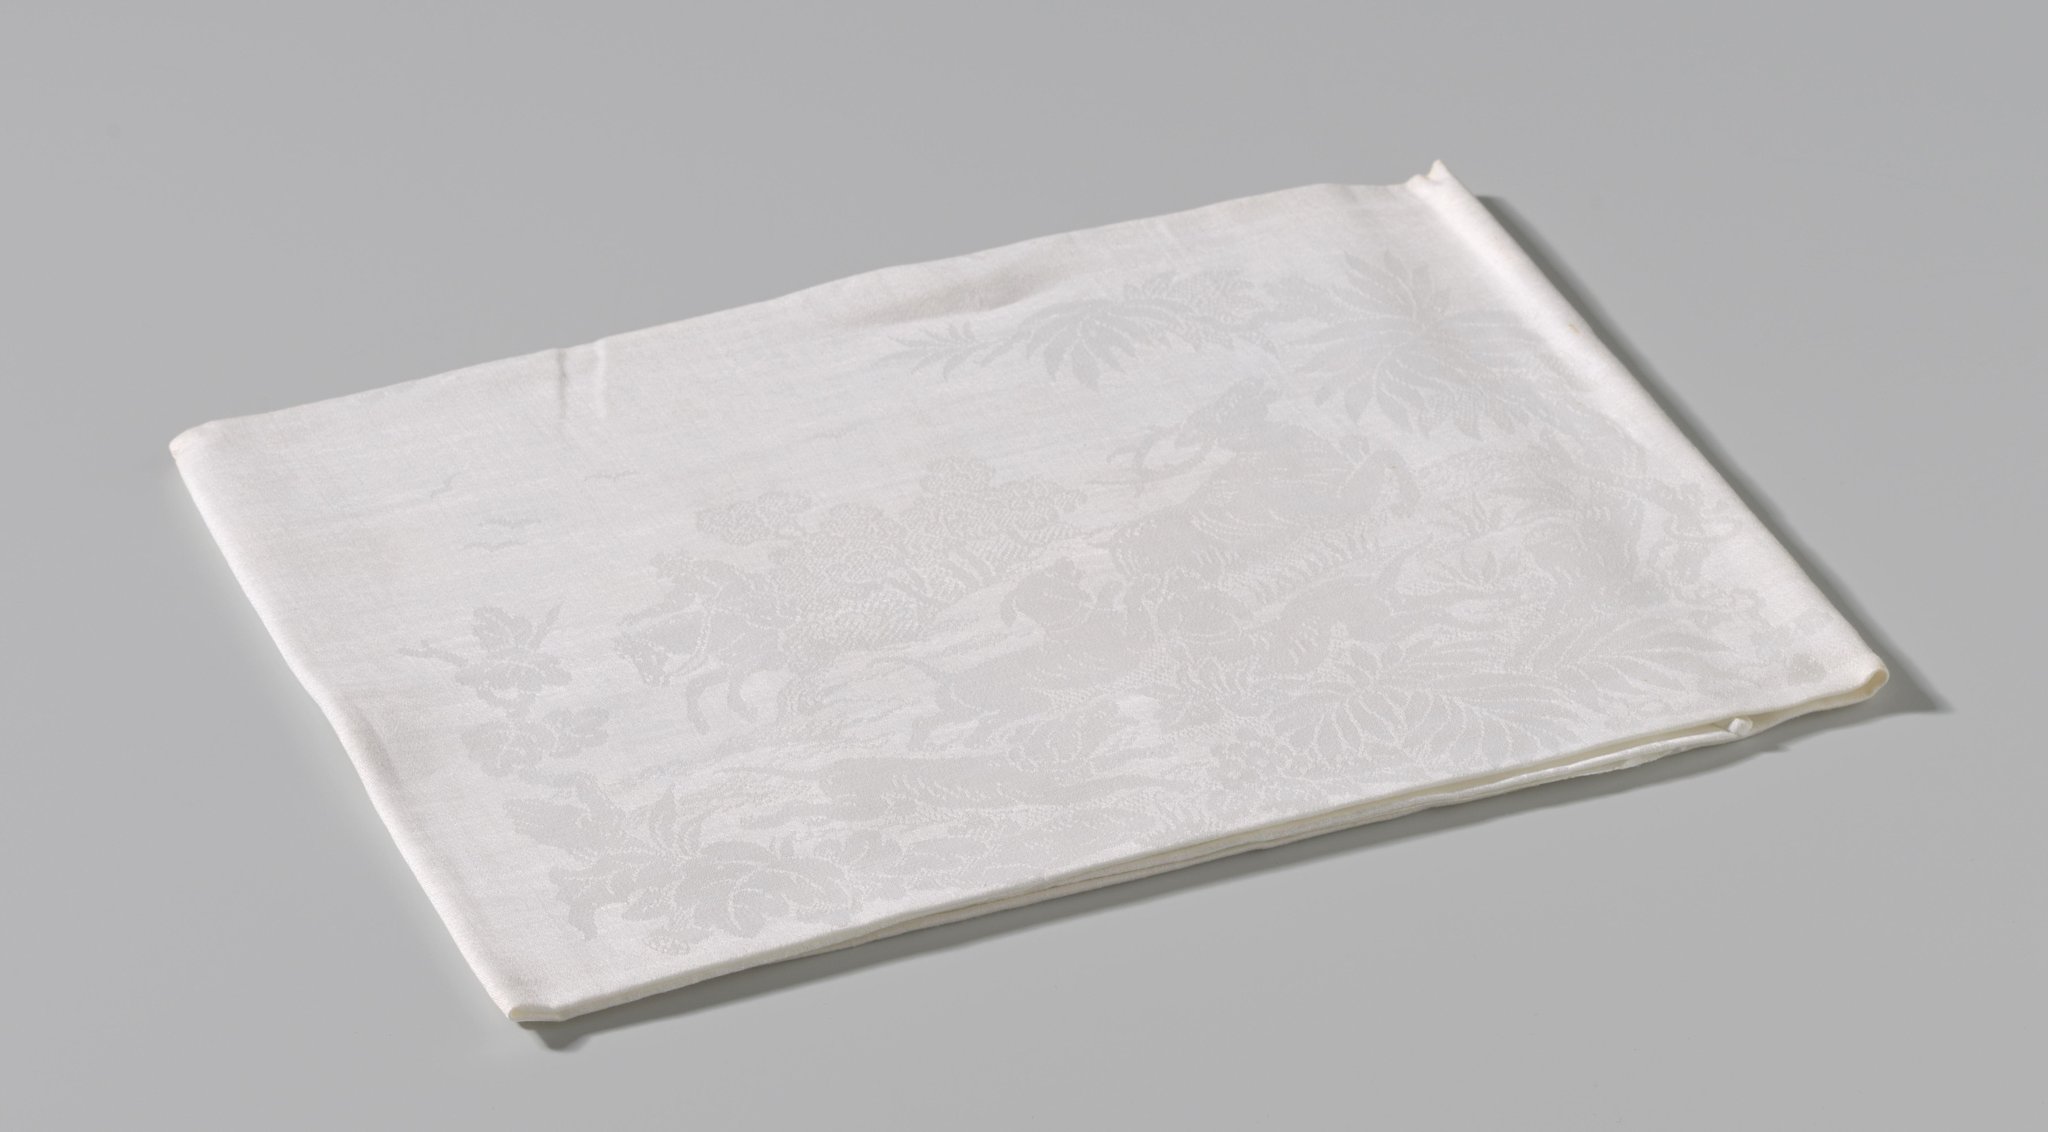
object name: napkin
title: Servet van linnendamast met een wapen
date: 1867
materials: linen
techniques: damask, weave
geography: veghel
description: Servet van linnendamast met het wapen van Schimmelpenninck. Het servet hoort bij elf servetten (BK-1973-216-A t/m BK-1973-216-L) en een tafellaken (BK-1973-215).